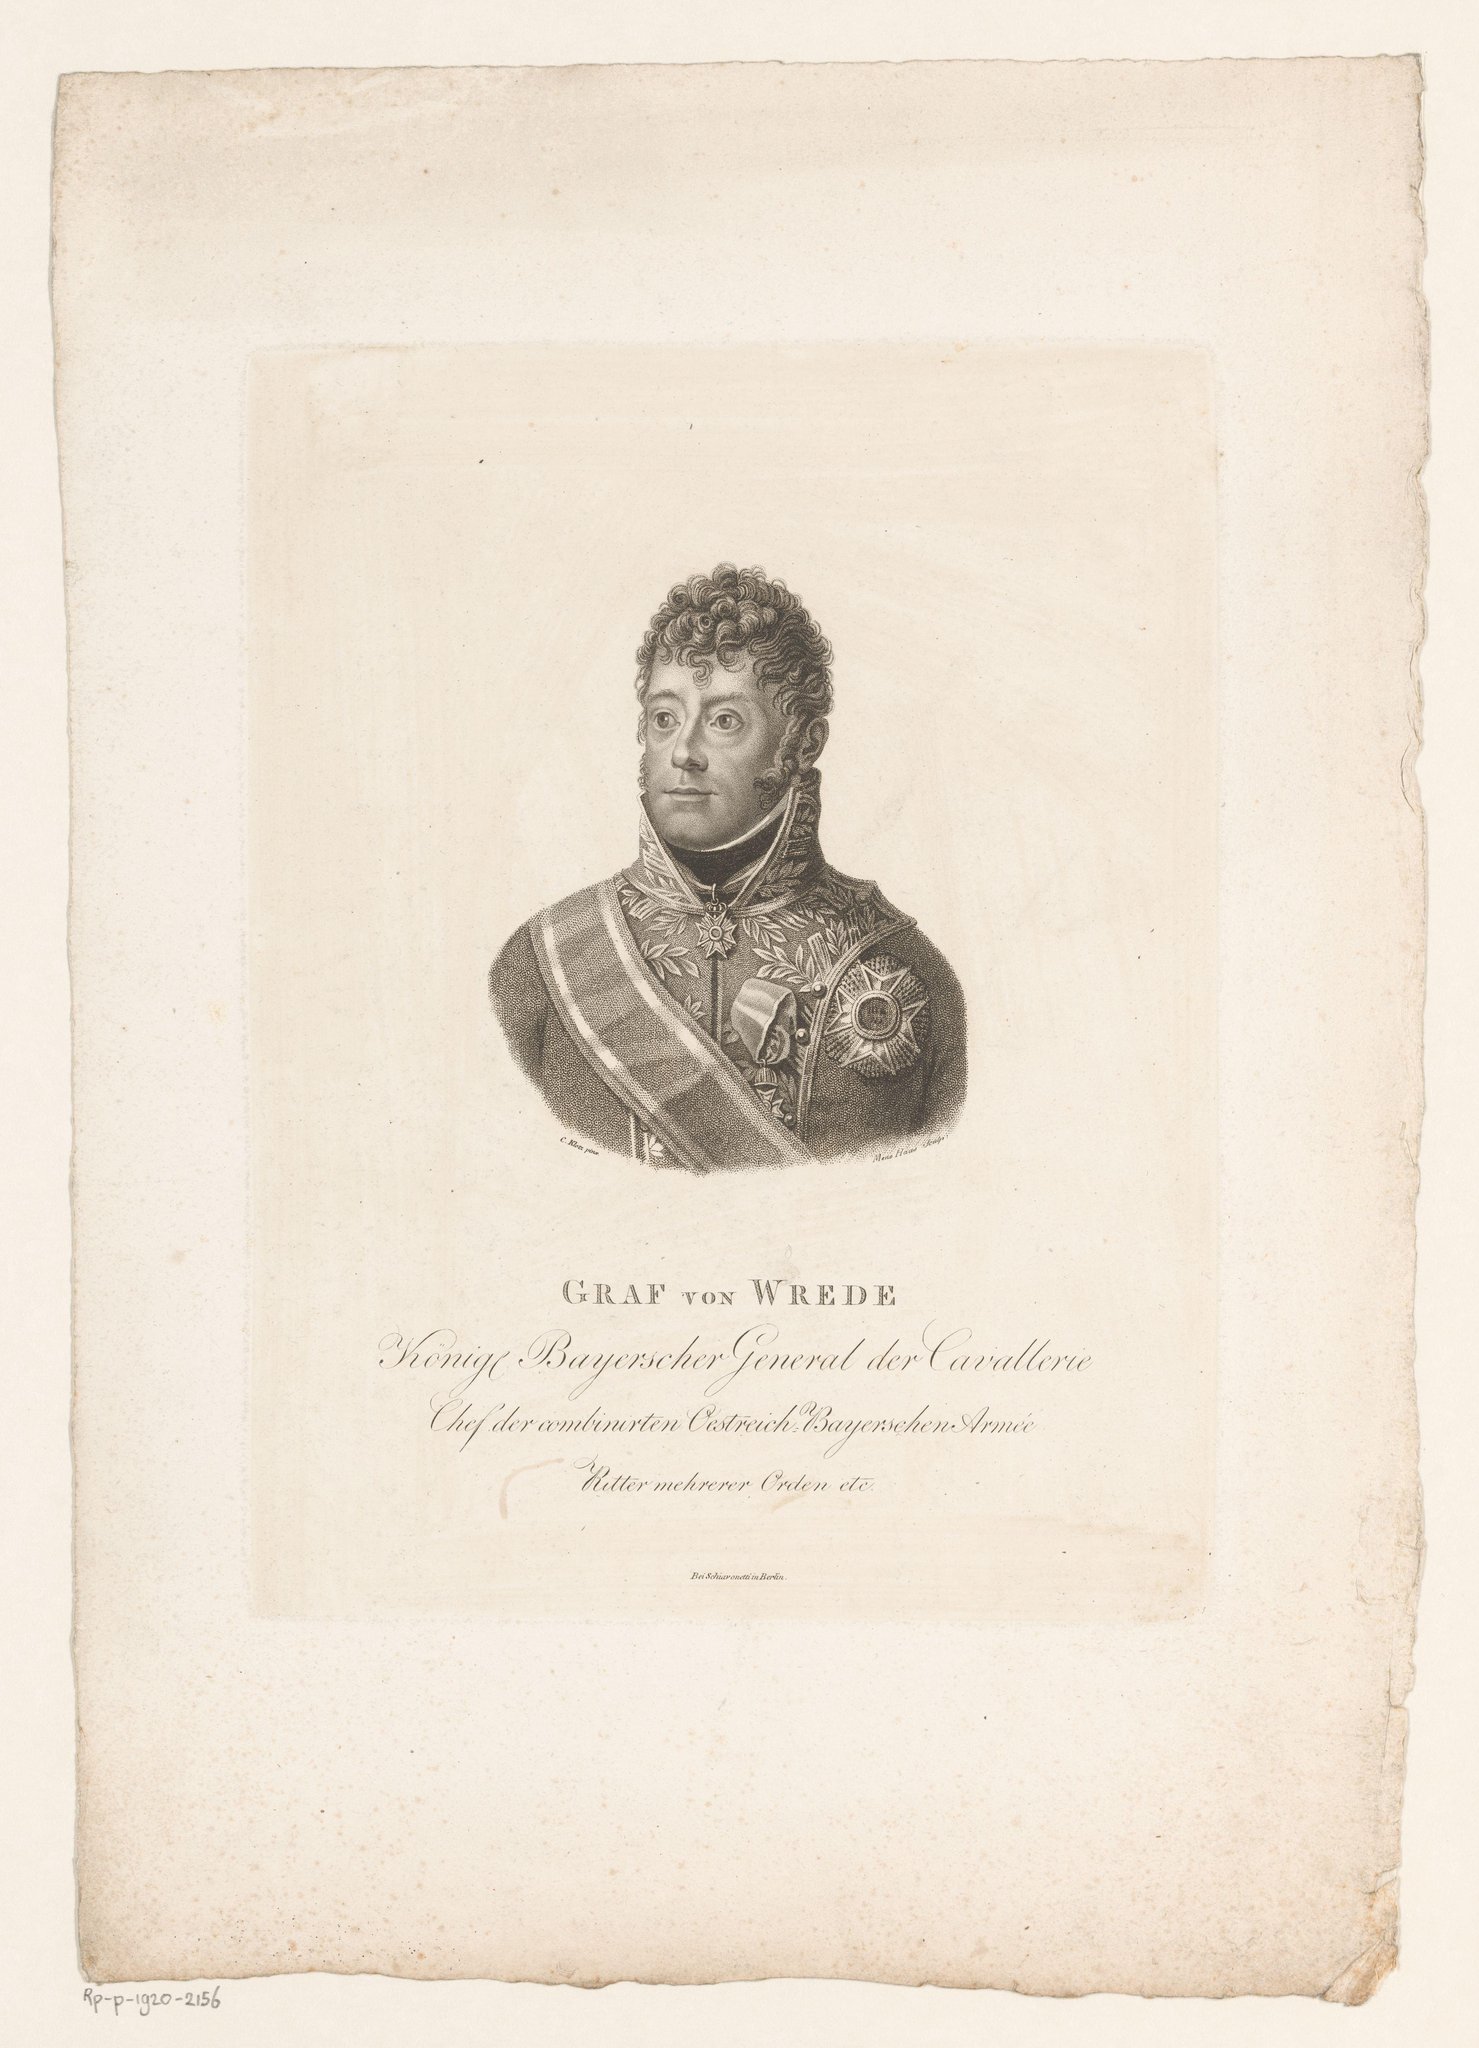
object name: print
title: Portret van Carl Philipp von Wrede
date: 1777-1833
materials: paper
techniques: stippling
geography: berlin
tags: knighthood order, commander-in-chief, general, marshal, historical persons, medals and other marks of military honour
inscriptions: collector's mark: Lugt 2228